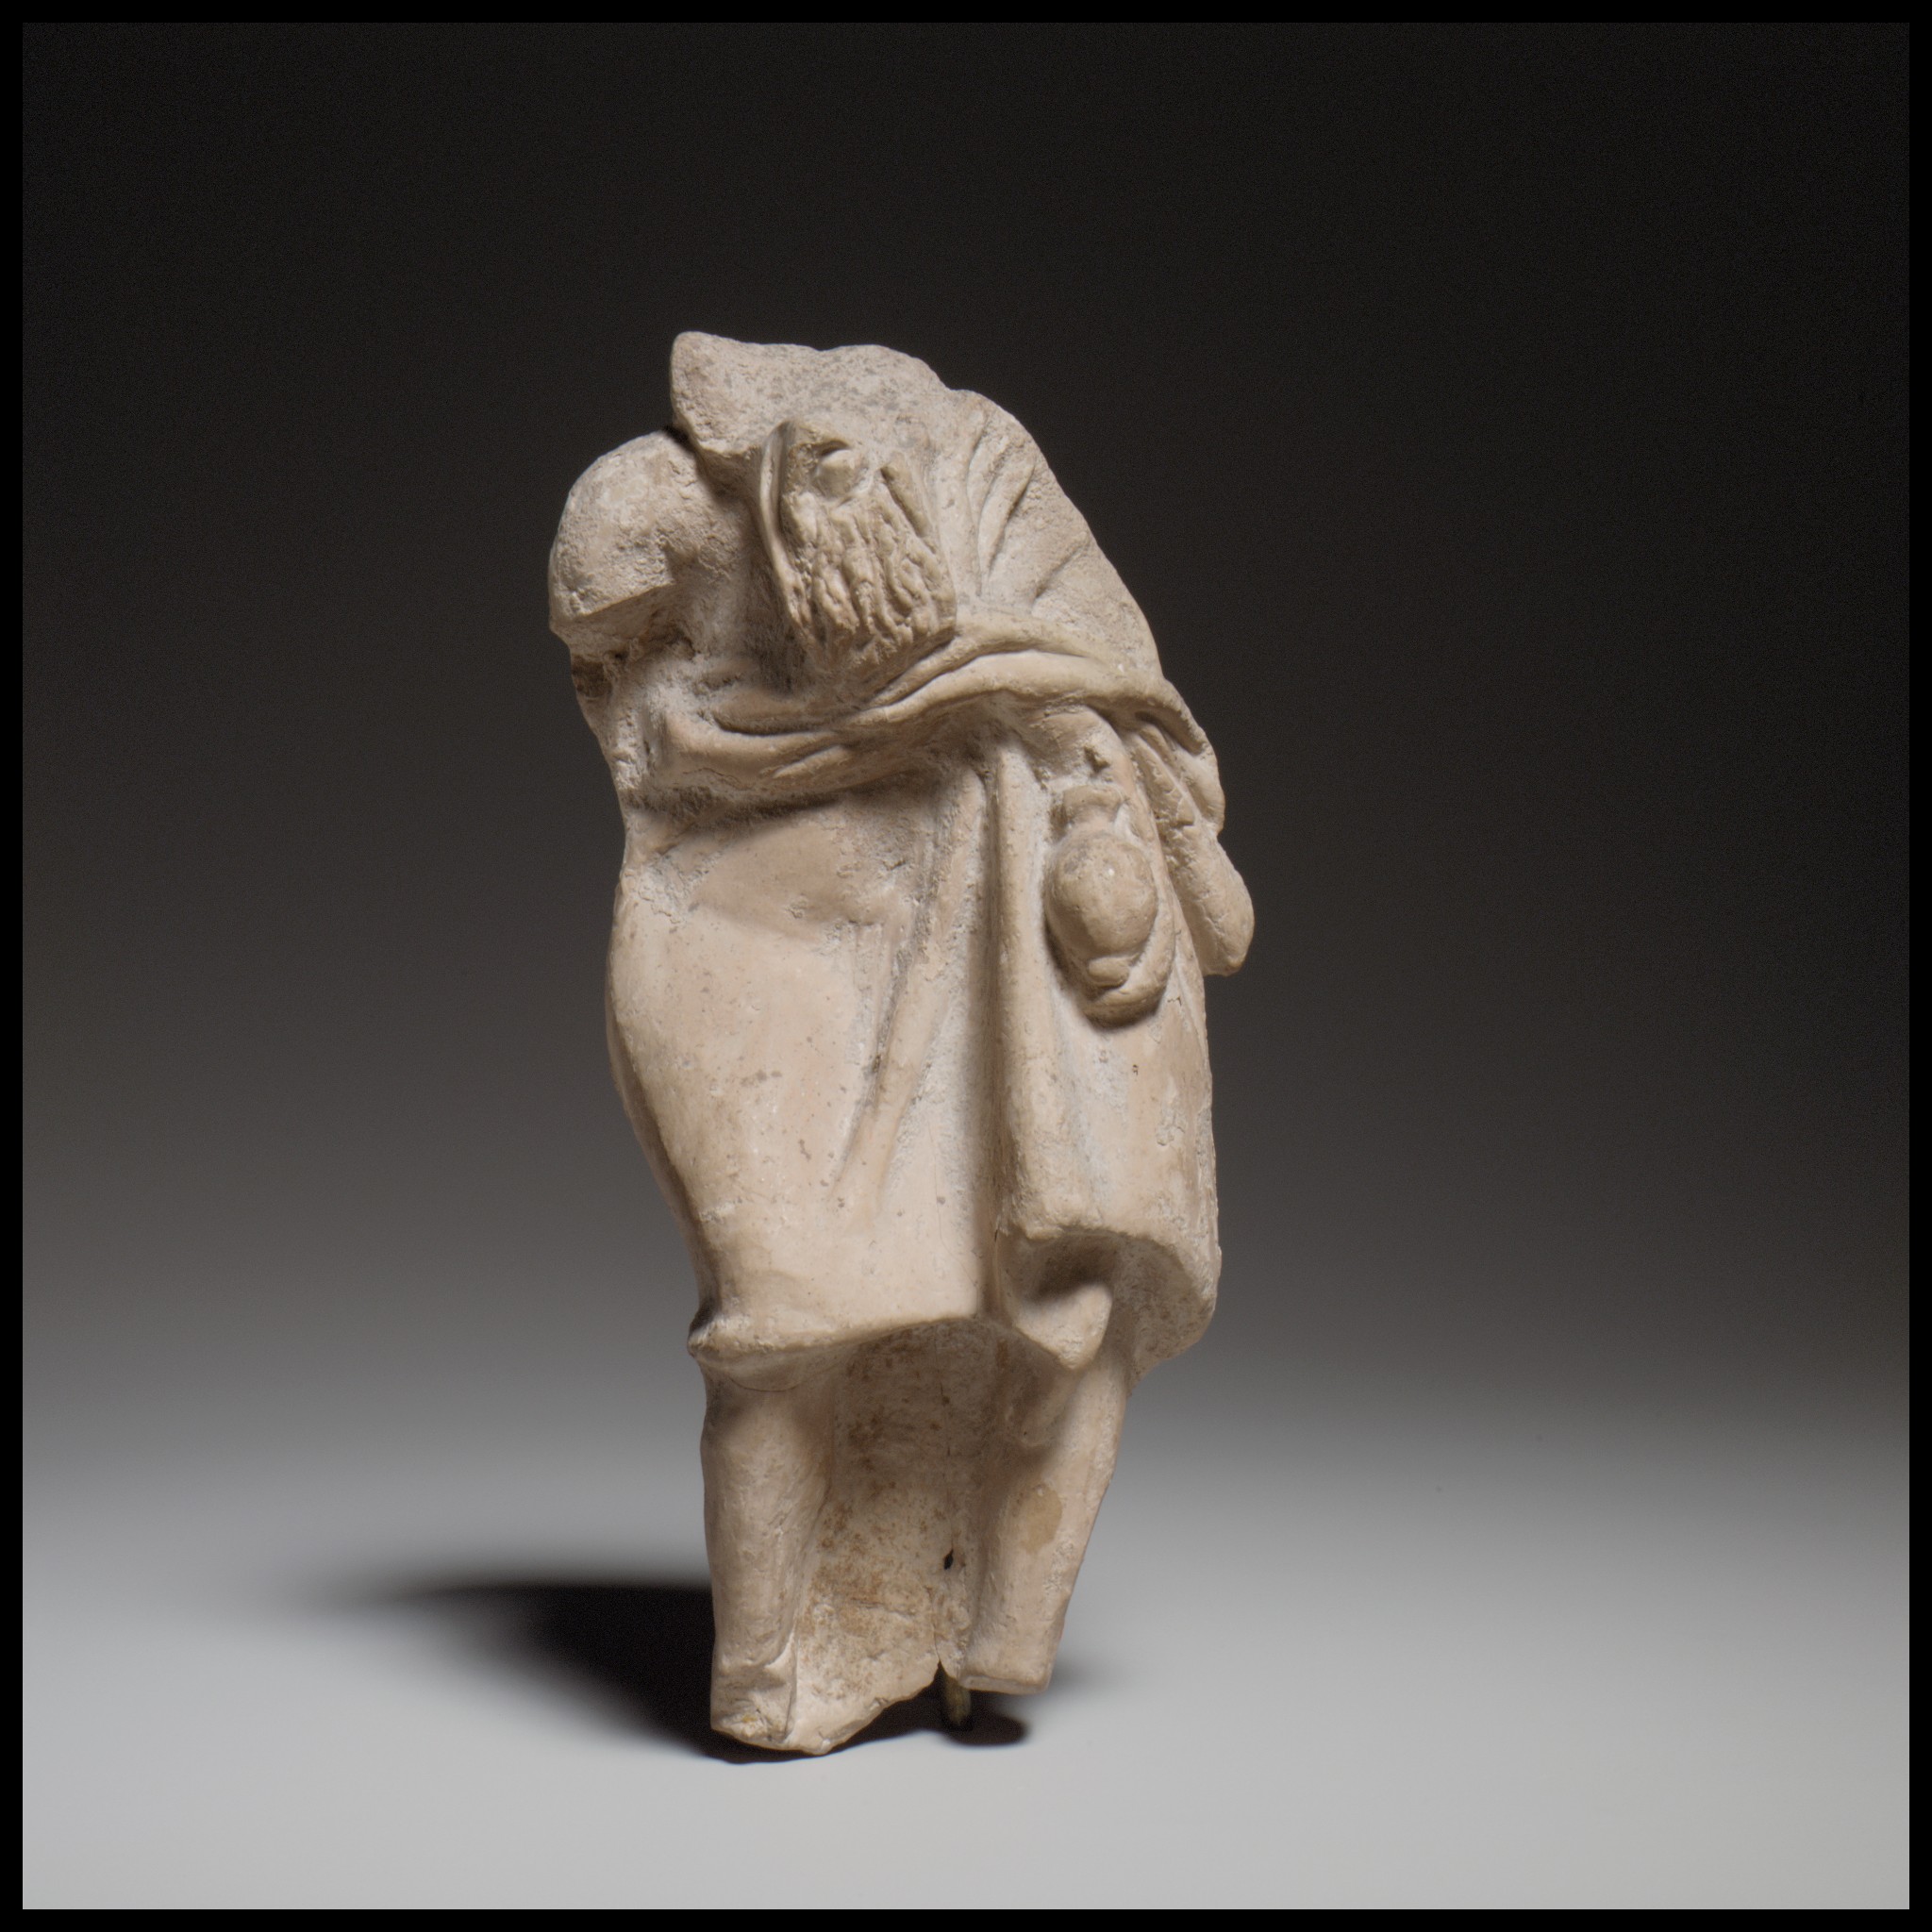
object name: figurine, comic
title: Terracotta comic figurine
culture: cypriot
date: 334-201 BCE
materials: terracotta